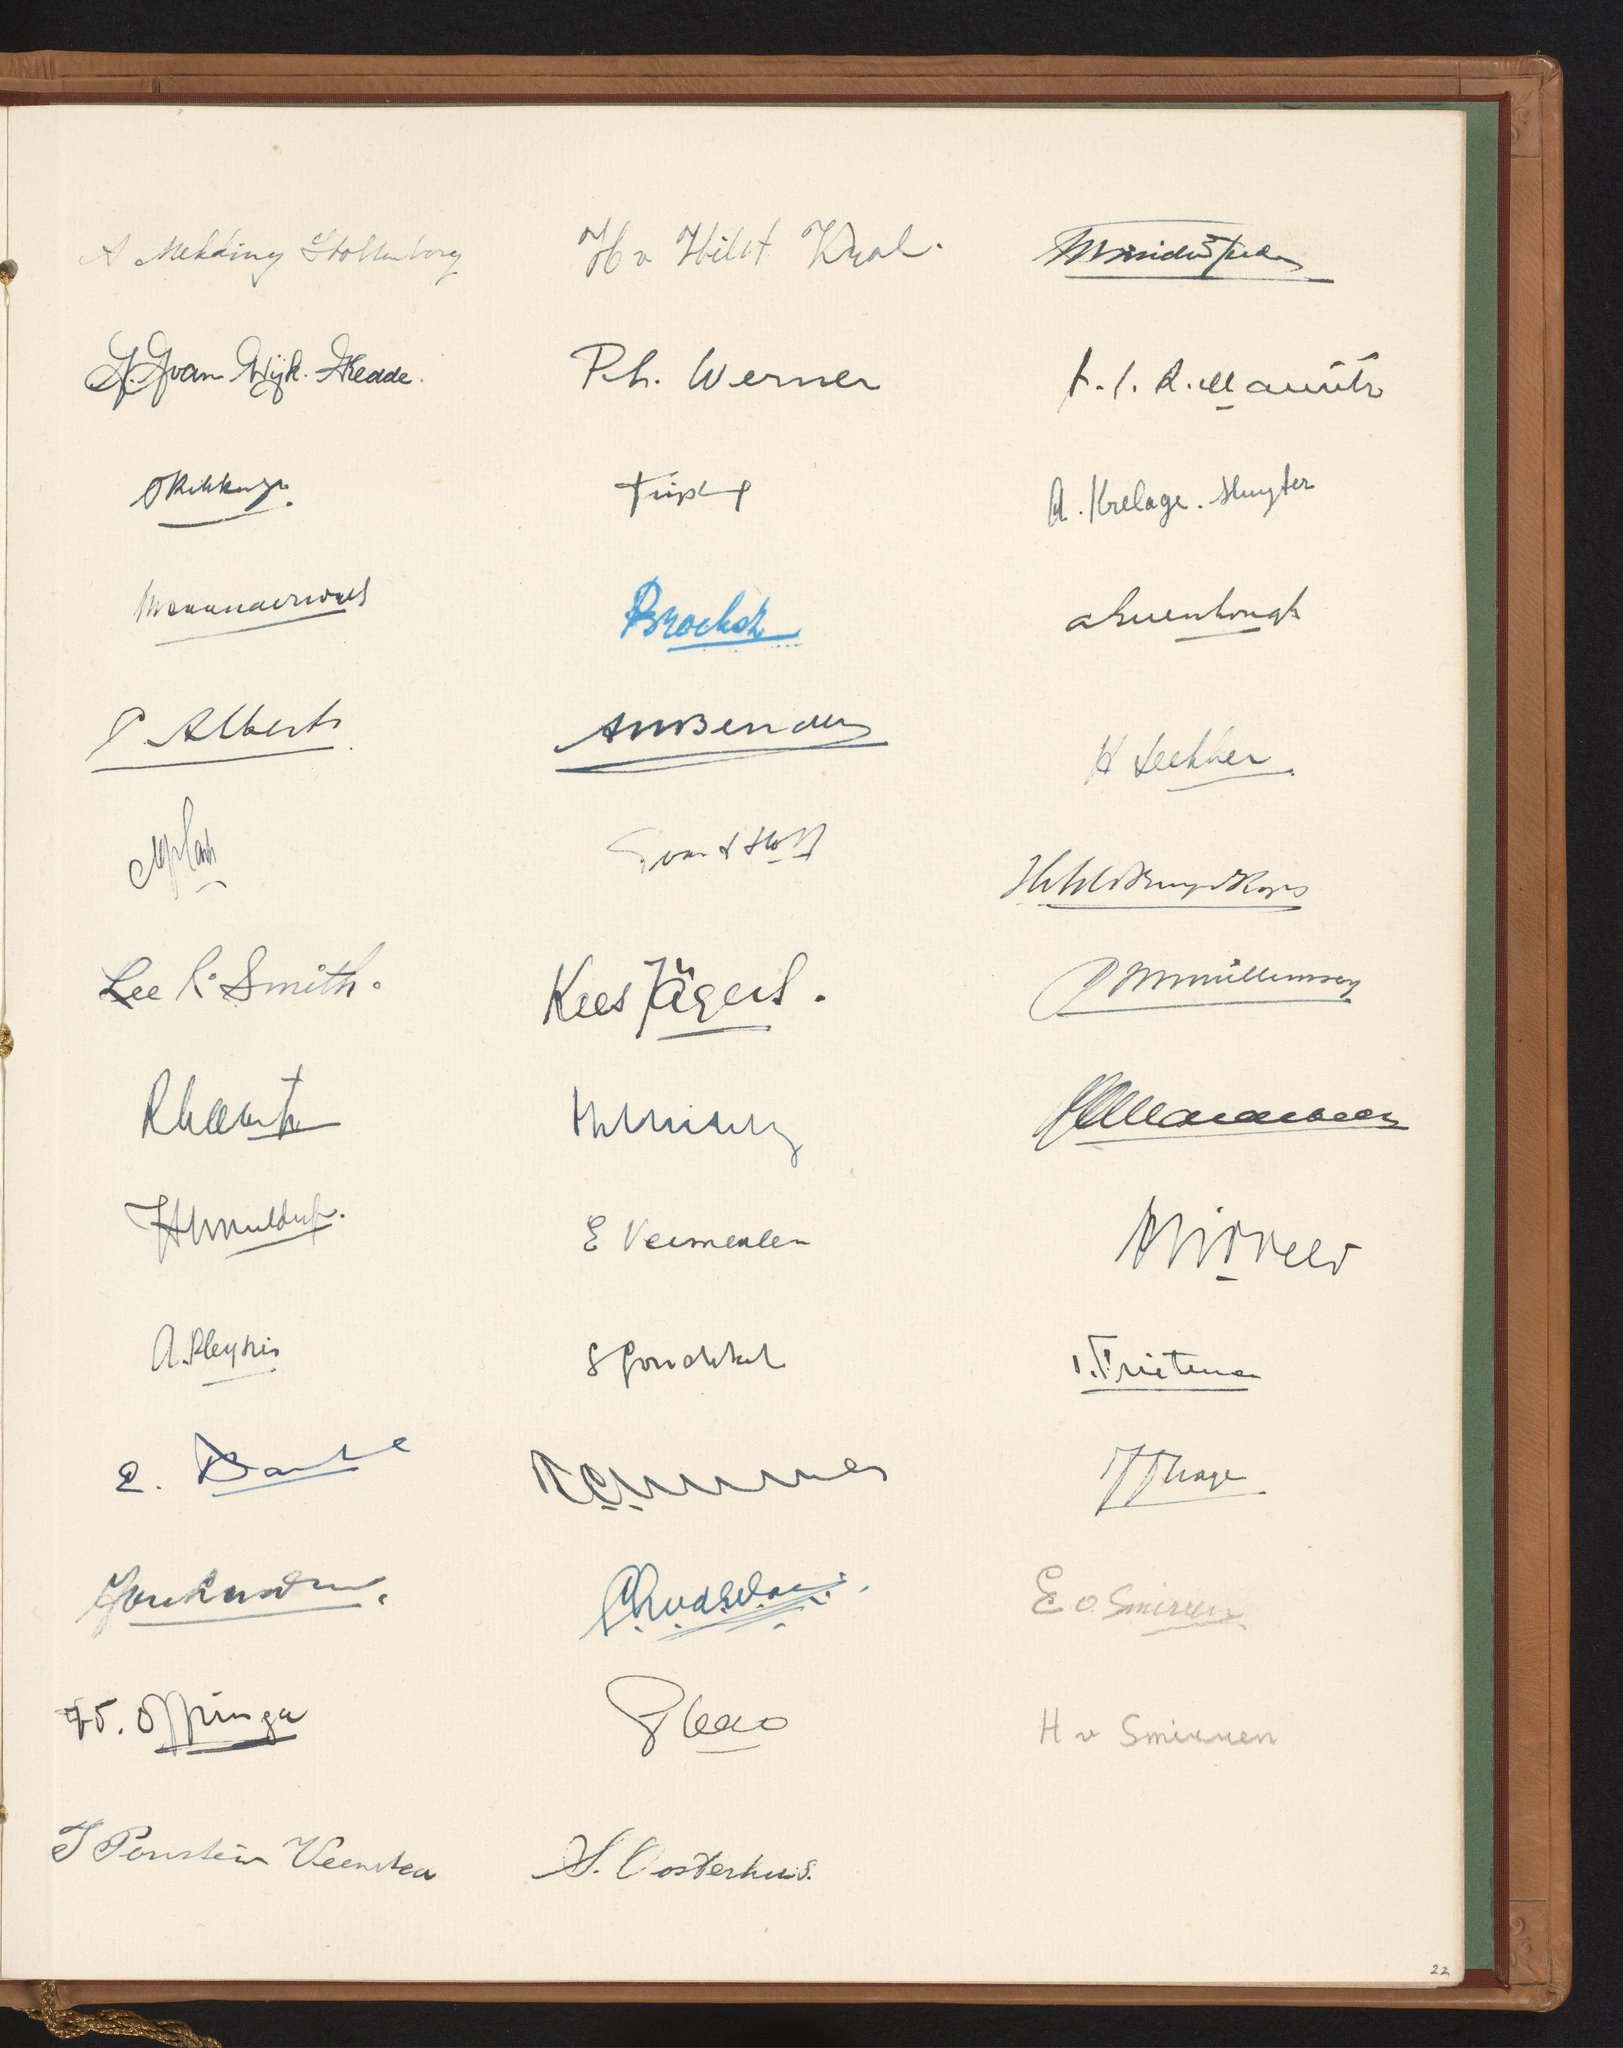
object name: text sheet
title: Blad met handtekeningen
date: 1949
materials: ink, paper, pencil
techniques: handwriting, pen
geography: netherlands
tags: modern professional organization, trade union, reception, cocktail party, handwriting, written text, amsterdam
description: Blad met handtekeningen van aanwezigen op het afscheidsfeest. Onderdeel van het fotoalbum ter gelegenheid van het afscheid van Evert Kupers als voorzitter van de NVV op 14 juli 1949 in Amsterdam.